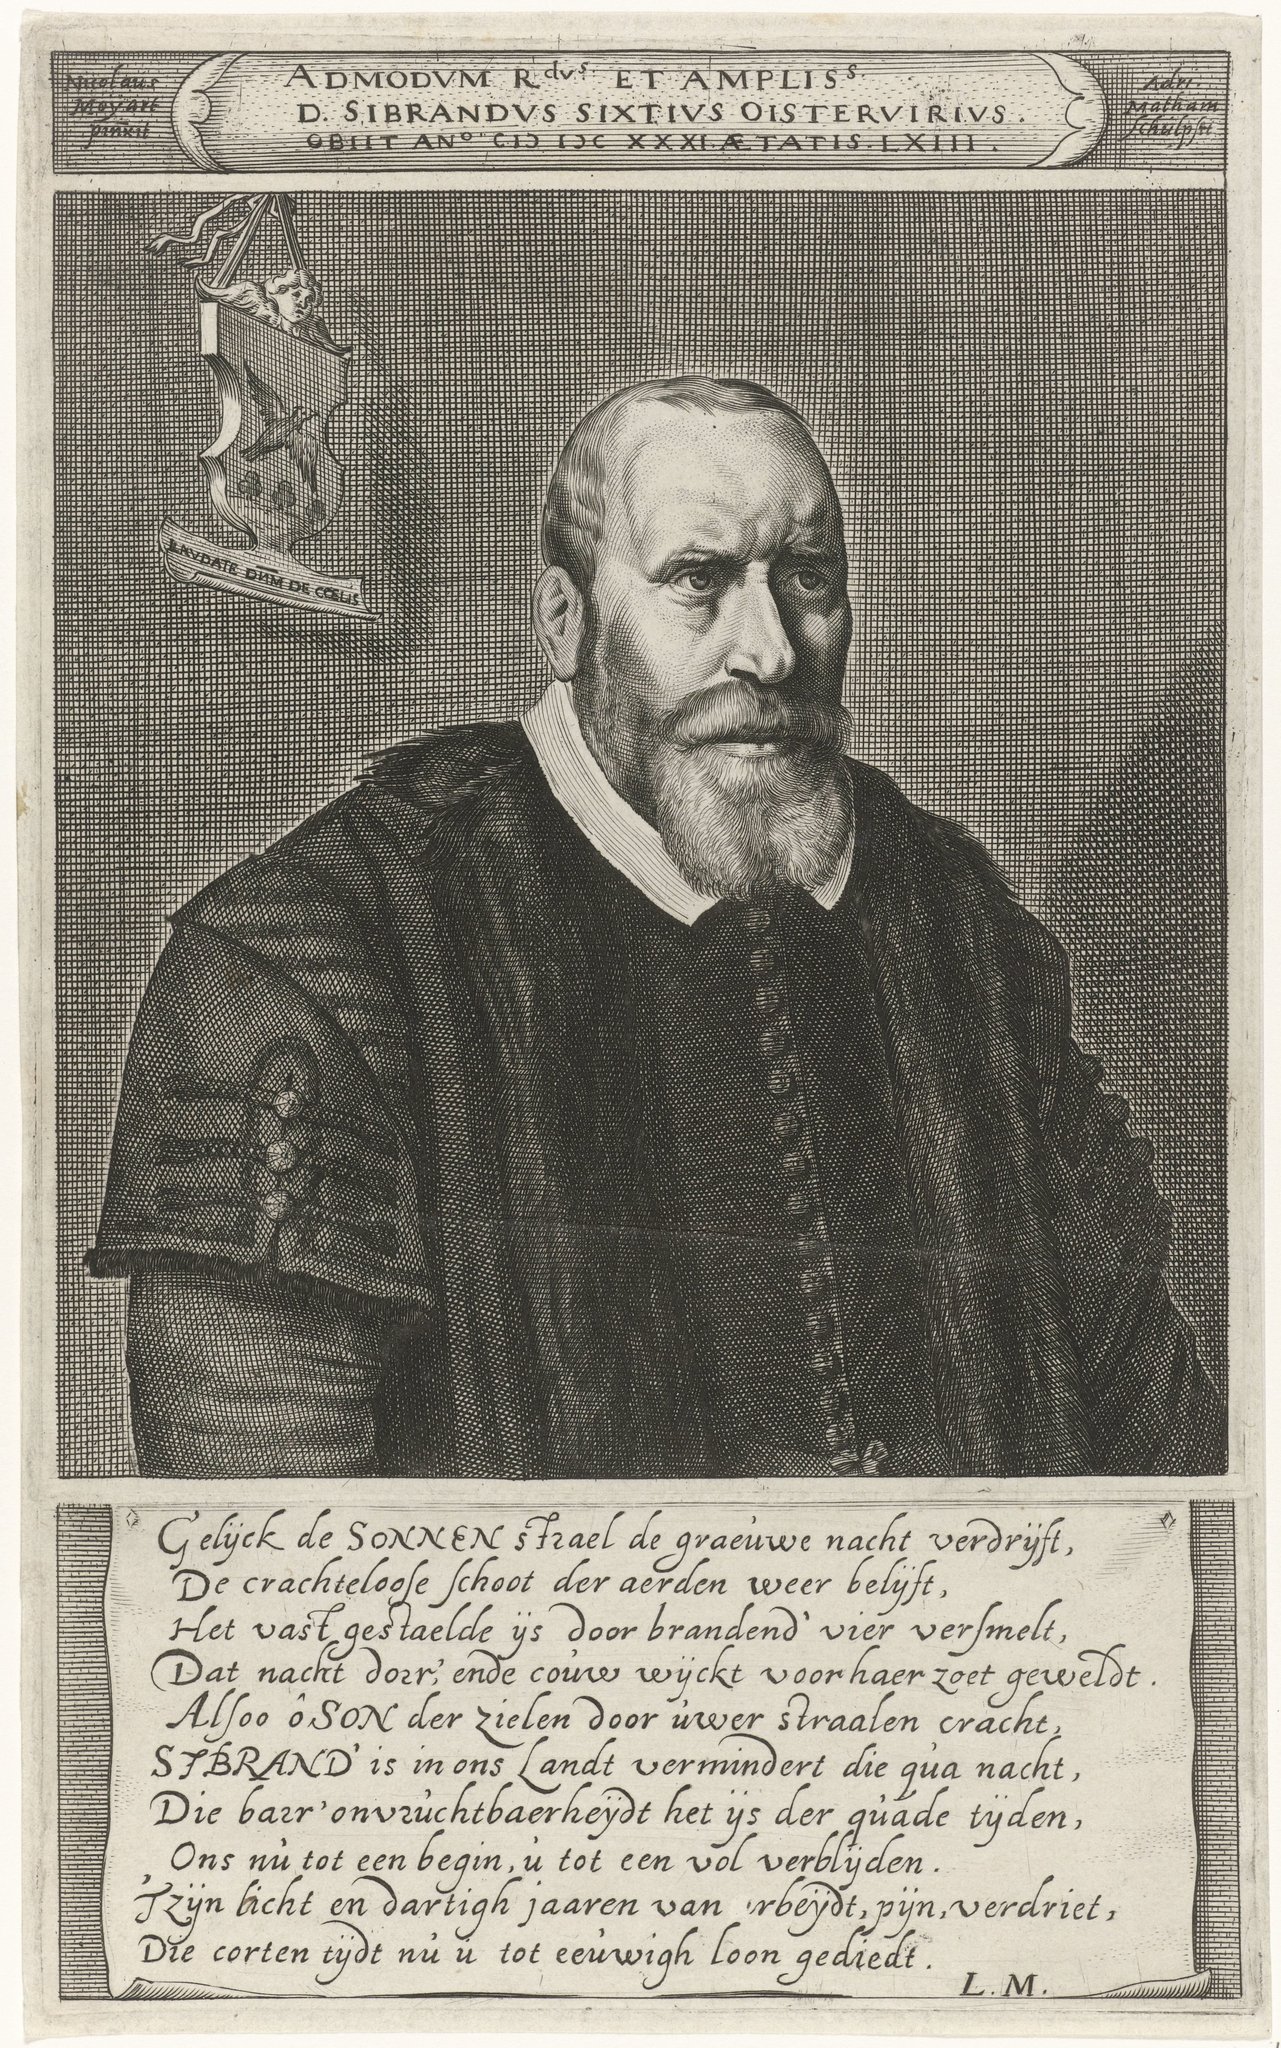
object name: print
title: Portret van Sibrandus Sixtius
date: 1631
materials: paper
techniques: engraving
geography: haarlem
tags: amsterdam, theologian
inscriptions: collector's mark: Lugt 2228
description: Portret van Sibrandus Sixtius, katholiek theoloog in Haarlem, op 63-jarige leeftijd.